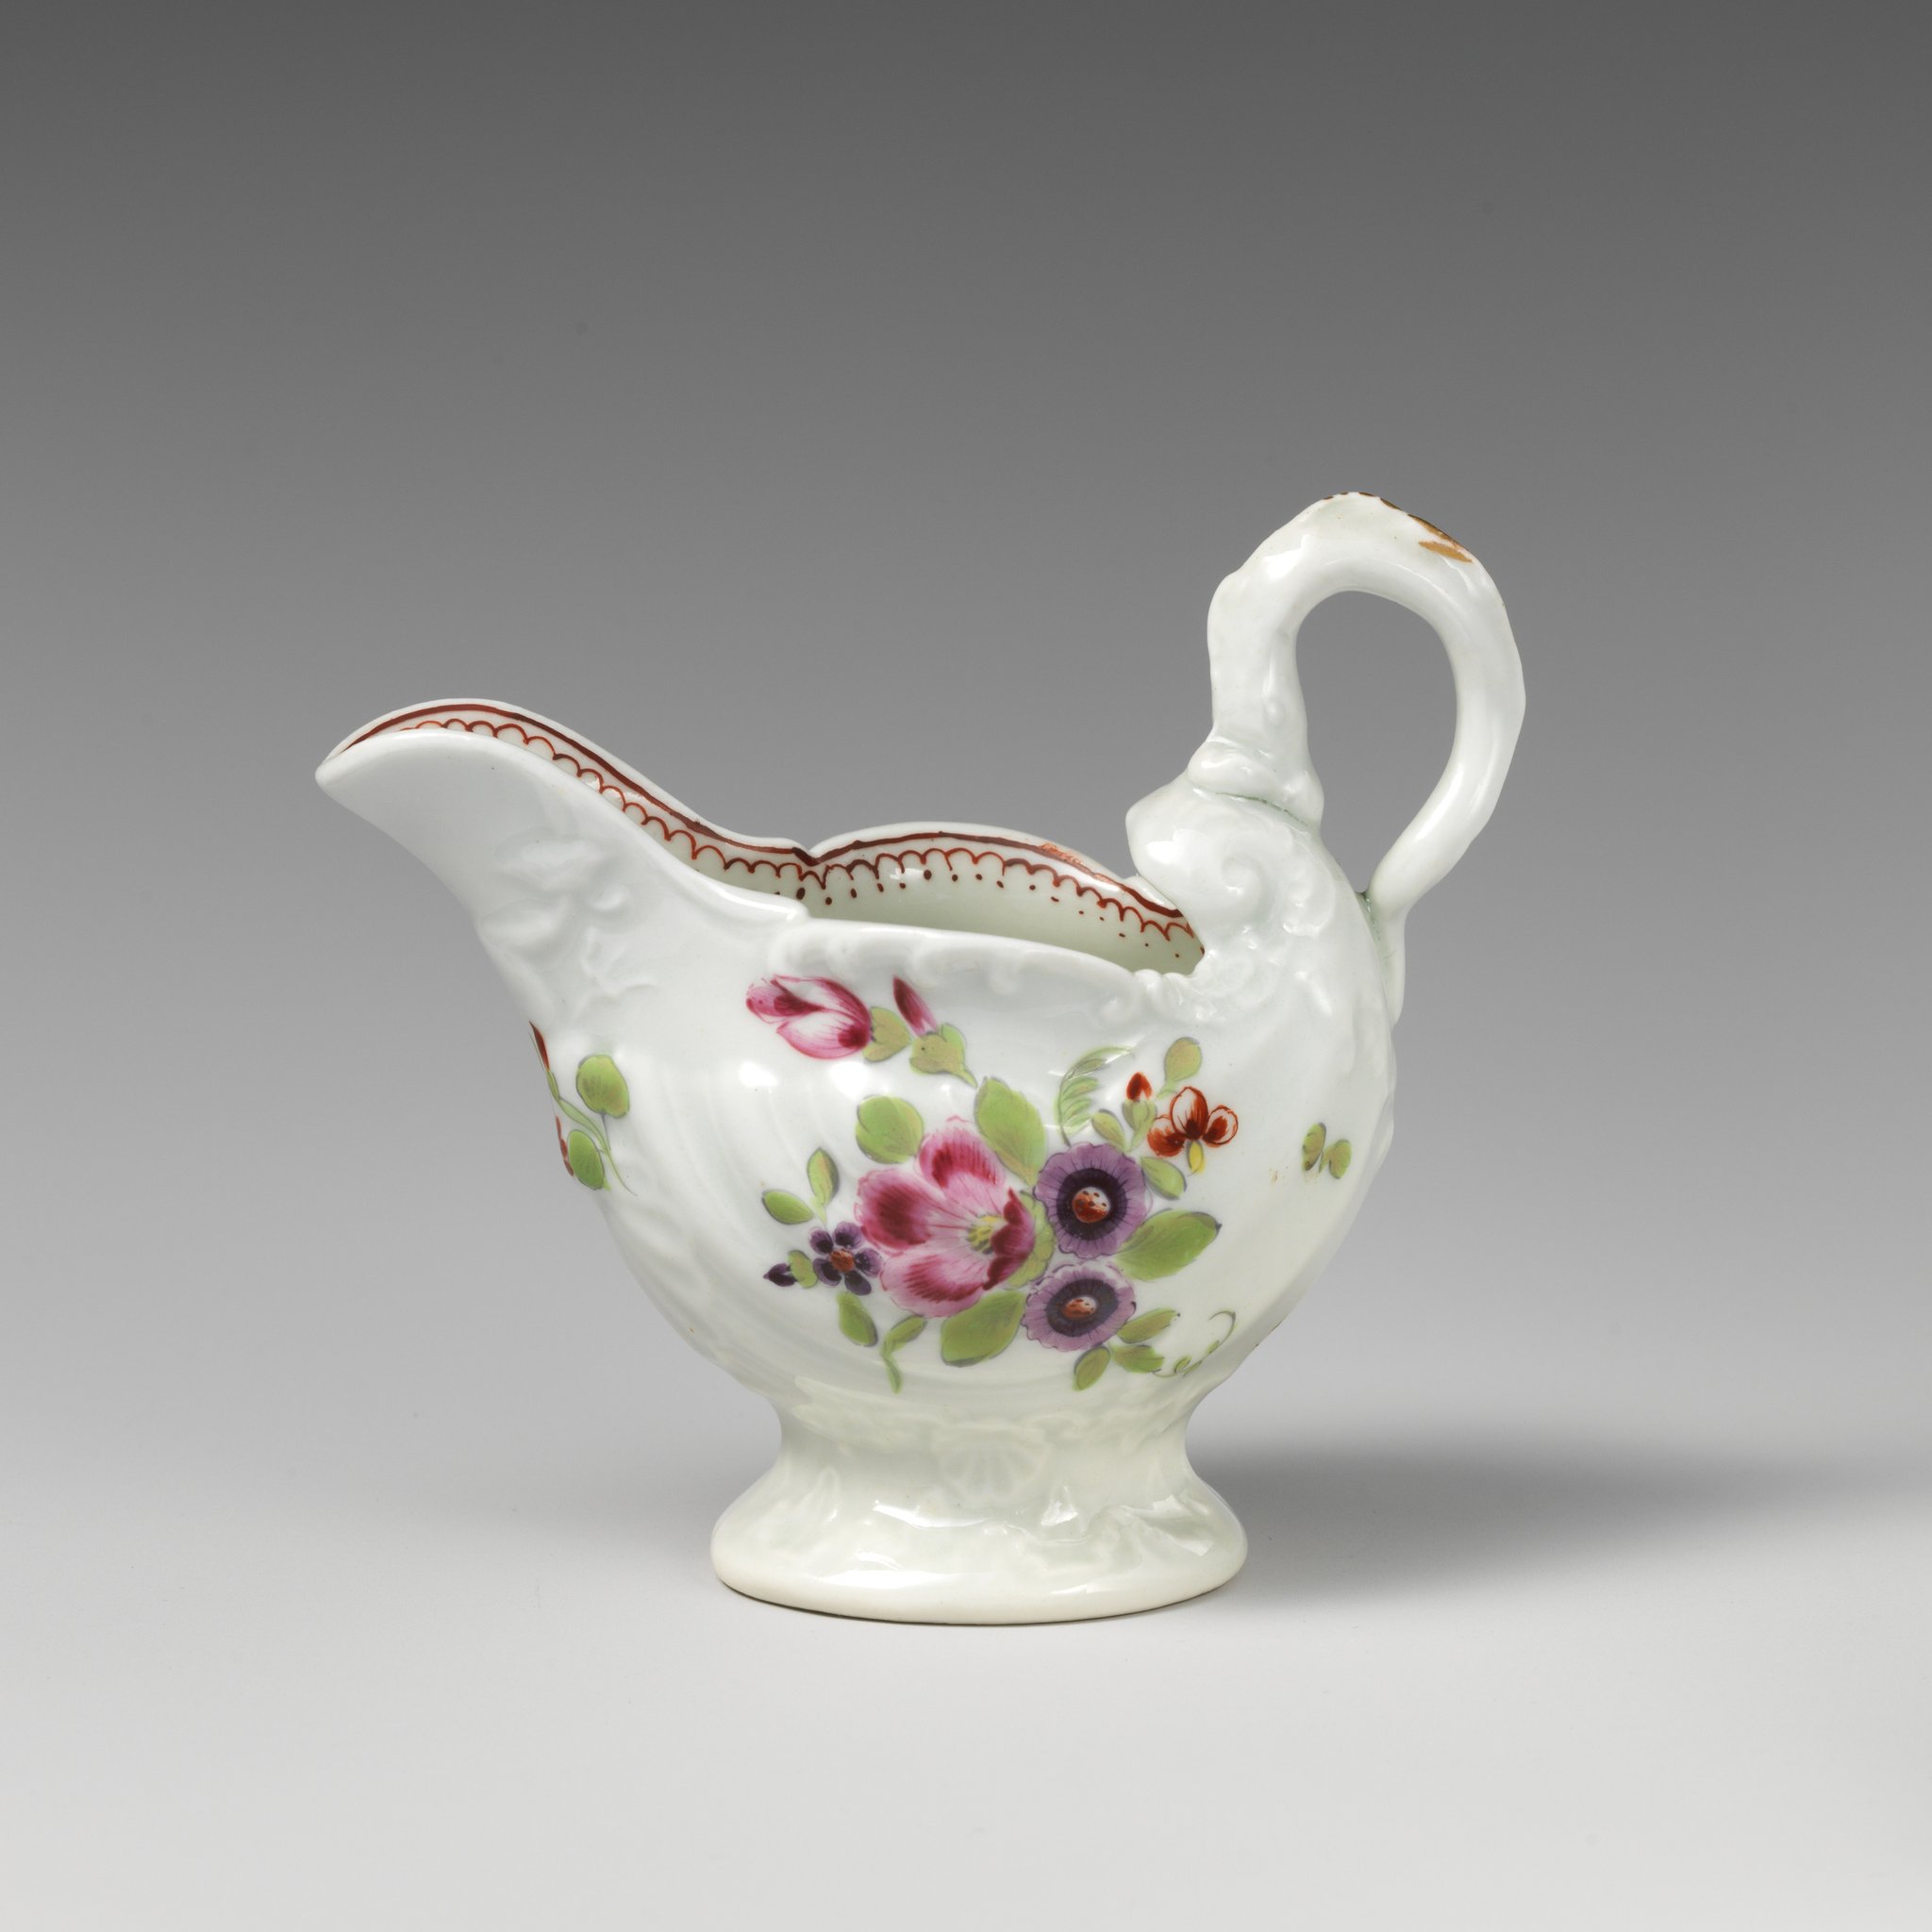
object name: cream jug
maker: worcester factory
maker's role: factory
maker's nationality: british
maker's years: 1751-2008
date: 1765-1770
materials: soft paste porcelain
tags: flowers